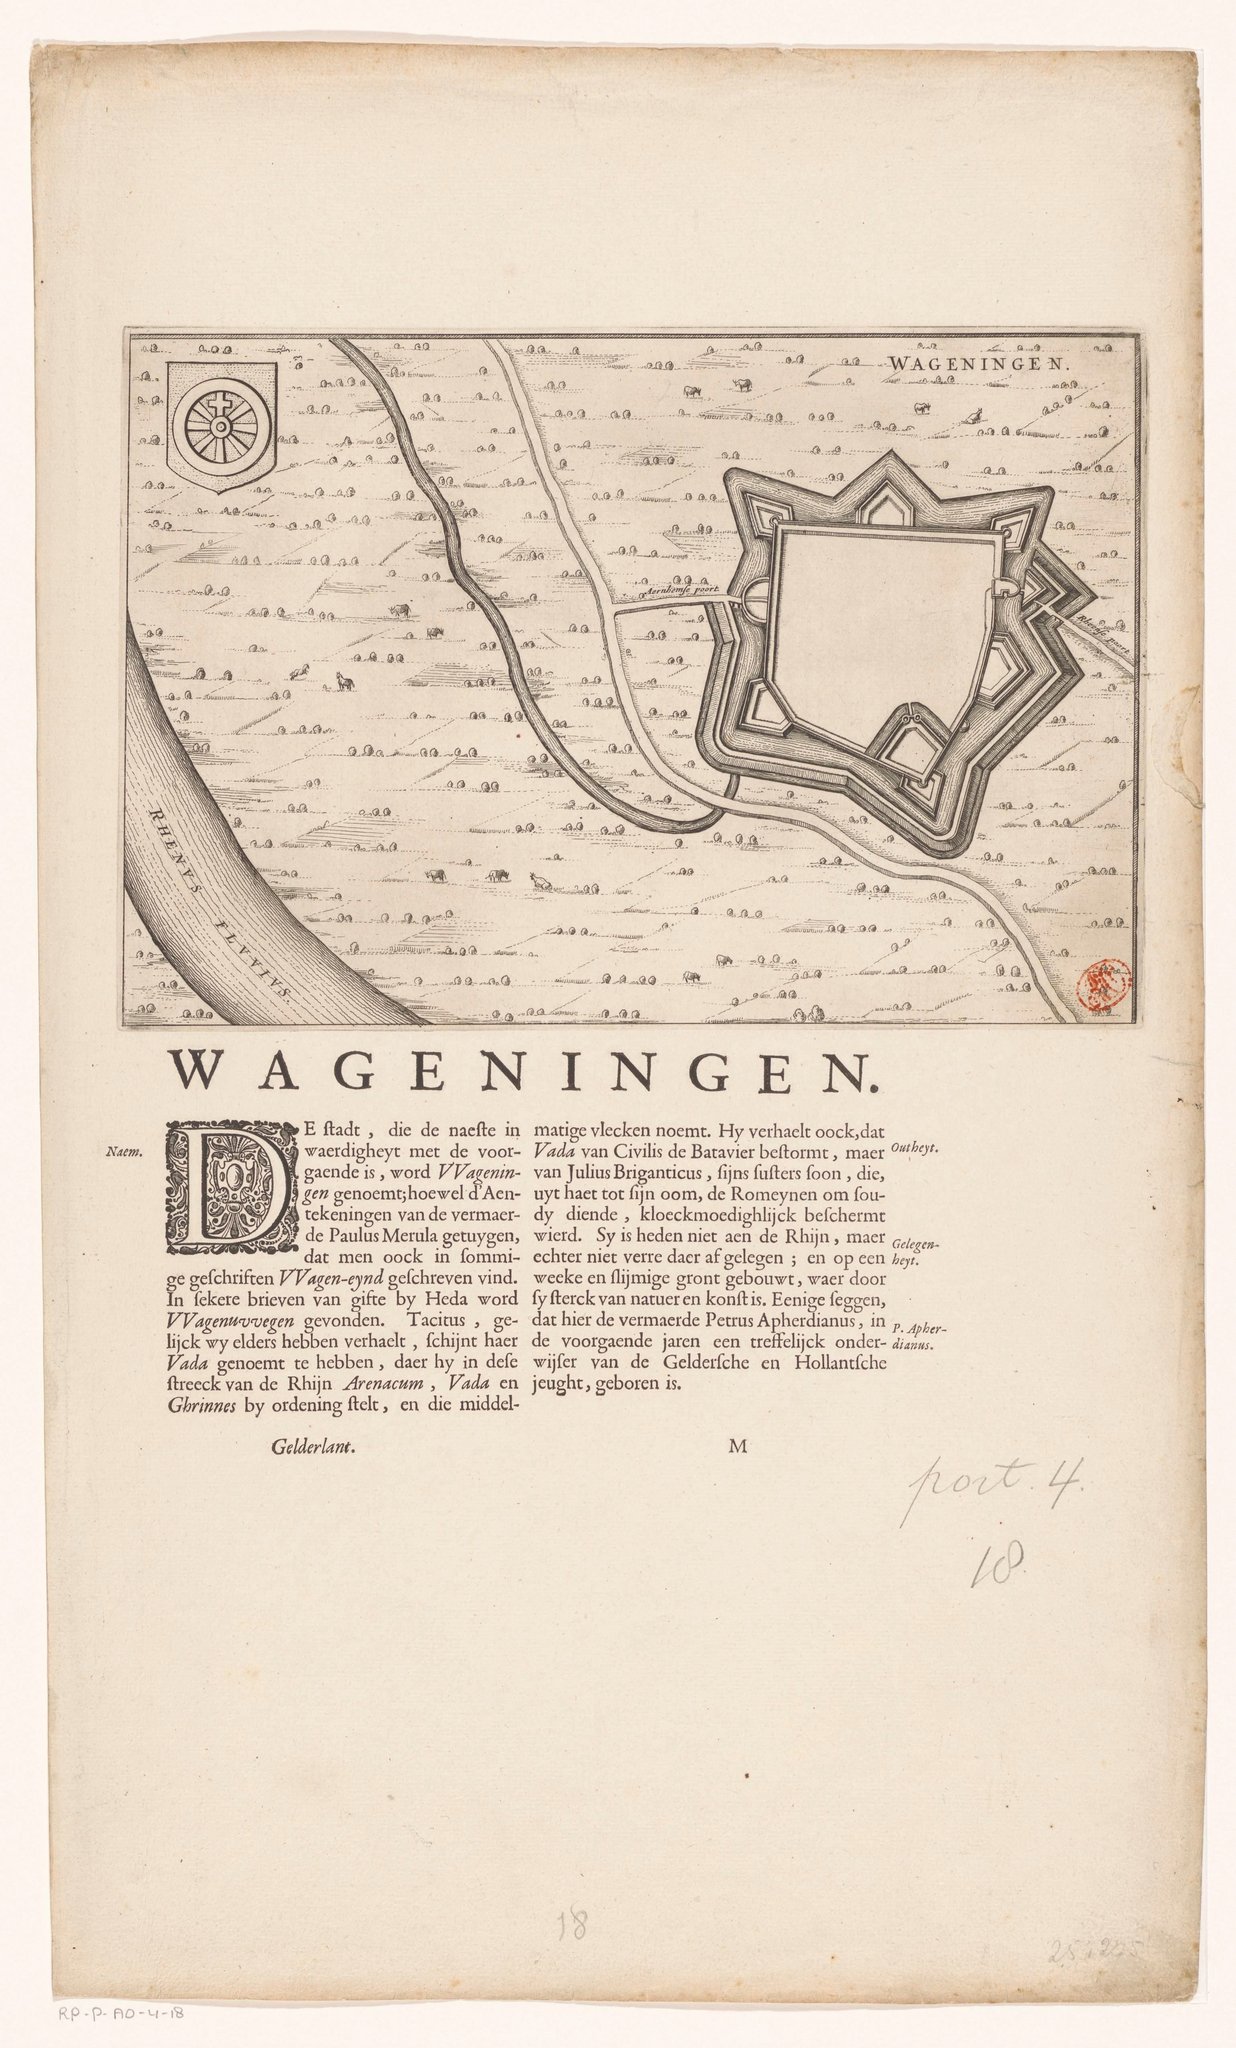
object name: area plan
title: Vestingplattegrond van Wageningen met beschrijving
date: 1652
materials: paper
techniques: engraving, etching, letterpress printing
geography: amsterdam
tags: fortress, coat of arms (as symbol of the state, etc.), maps of cities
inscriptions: collector's mark: Lugt 195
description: Prent gebruikt in: Blaeu, Johannes Willemszoon. Toonneel der steden van de Vereenighde Nederlanden. 2 delen. Amsterdam: Johannes Willemszoon Blaeu, 1652, dl. 1.